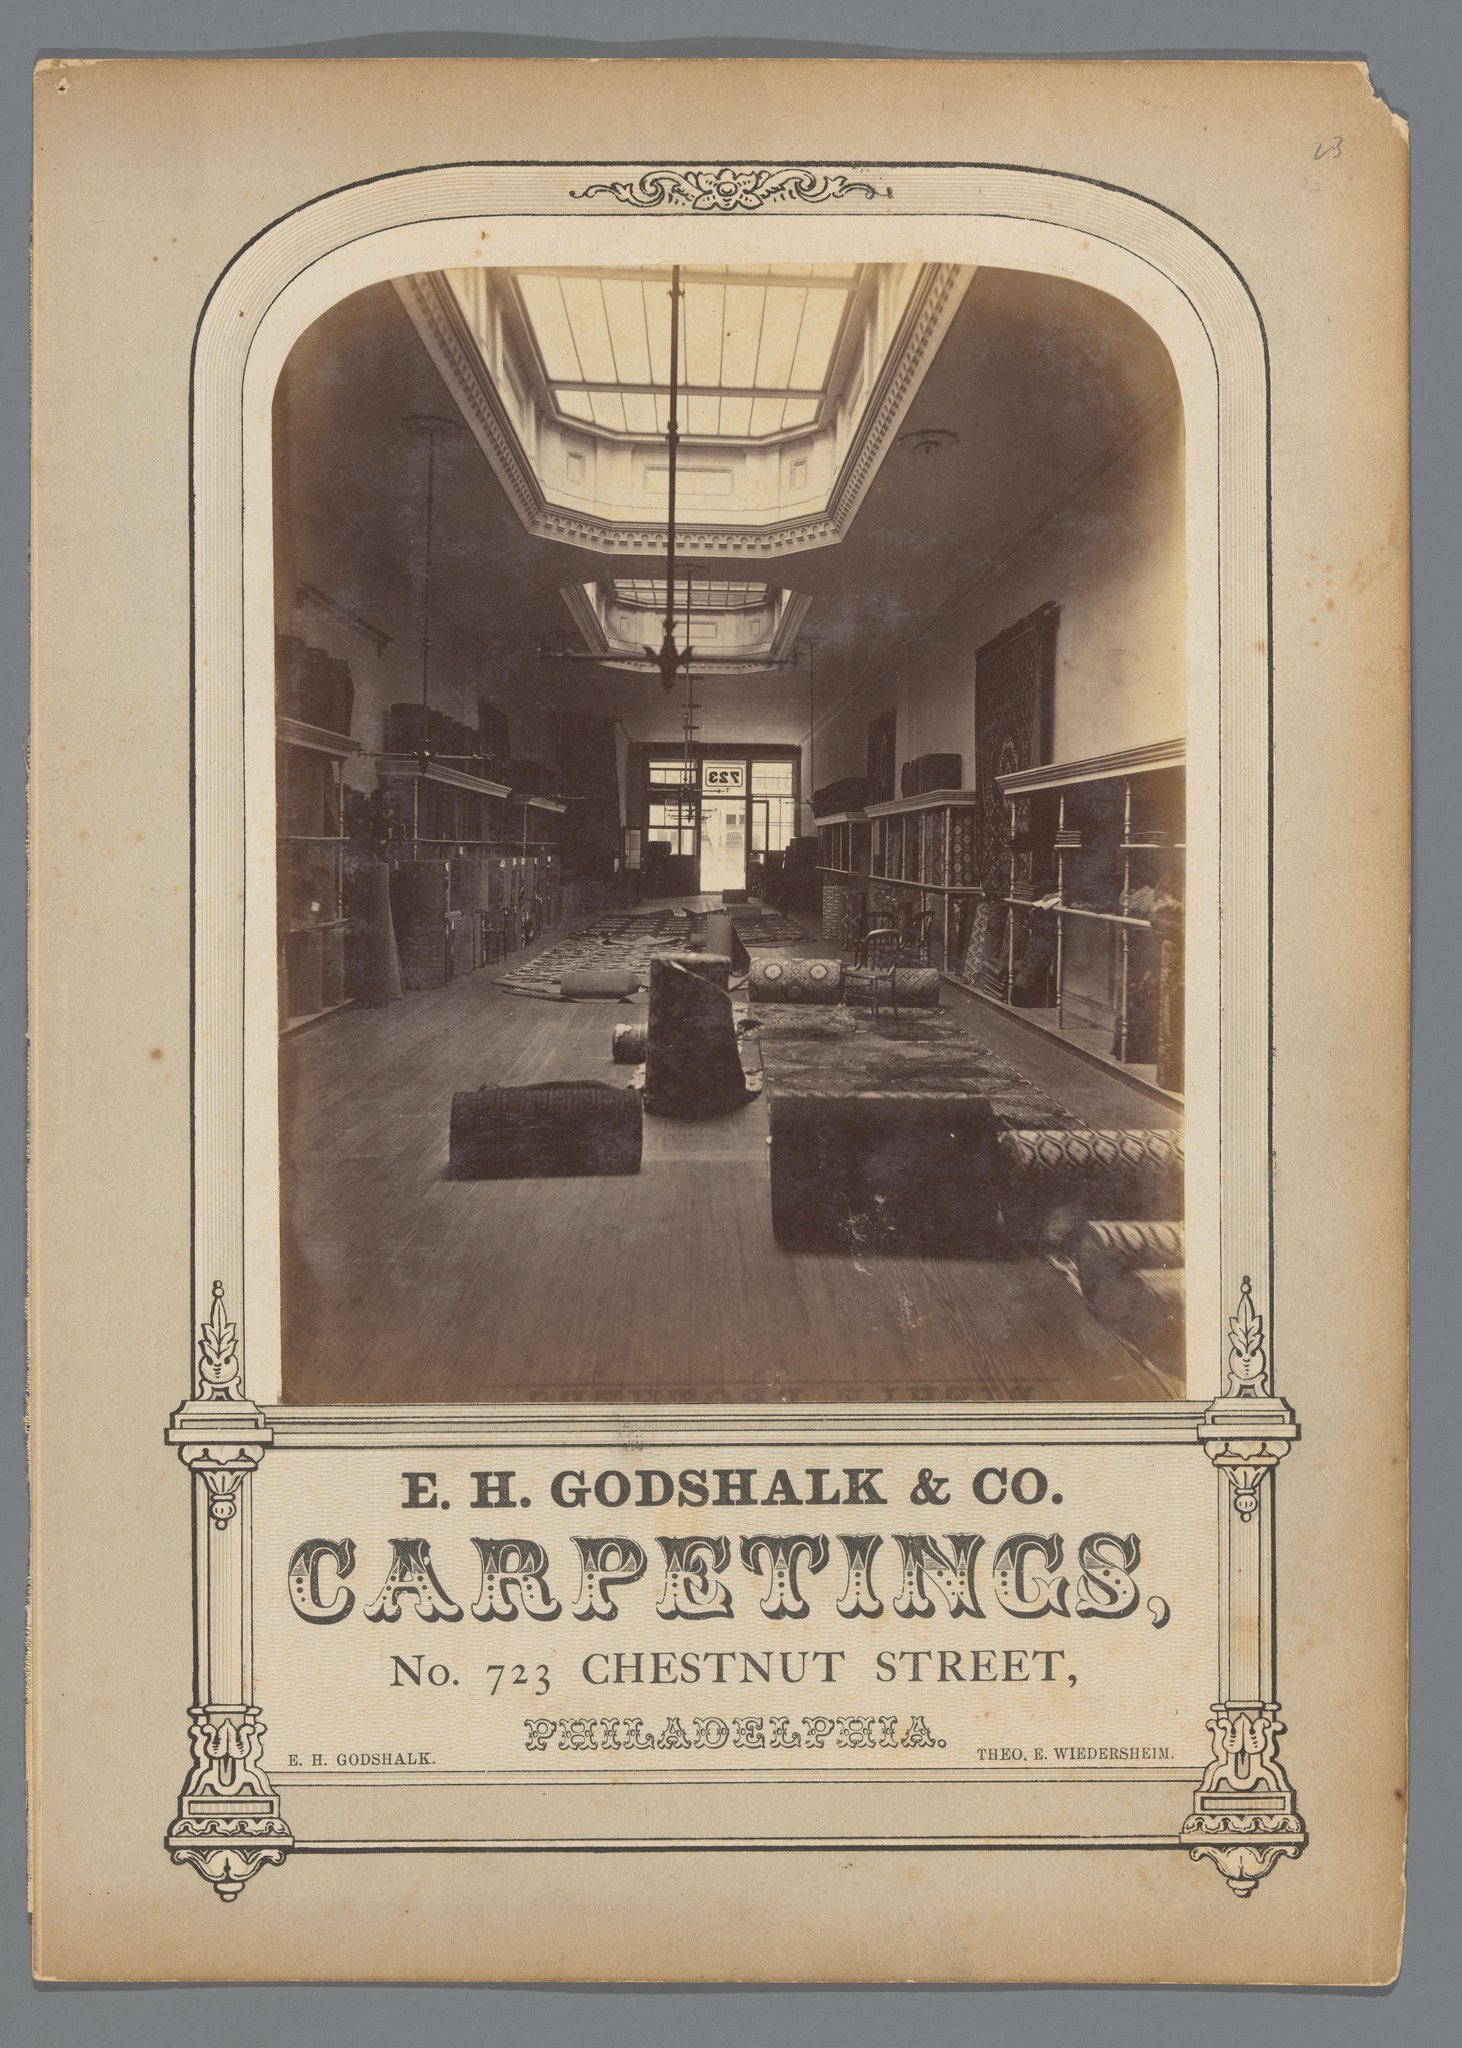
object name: photograph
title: Interieur van E.H. Godshalk & Co., Carpetings, 723 Chestnut Street, Philadelphia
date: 1871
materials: cardboard, paper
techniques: albumen print, printed materials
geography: philadelphia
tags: philadelphia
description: Pagina uit Gallery of Arts and Manufactures of Philadelphia.